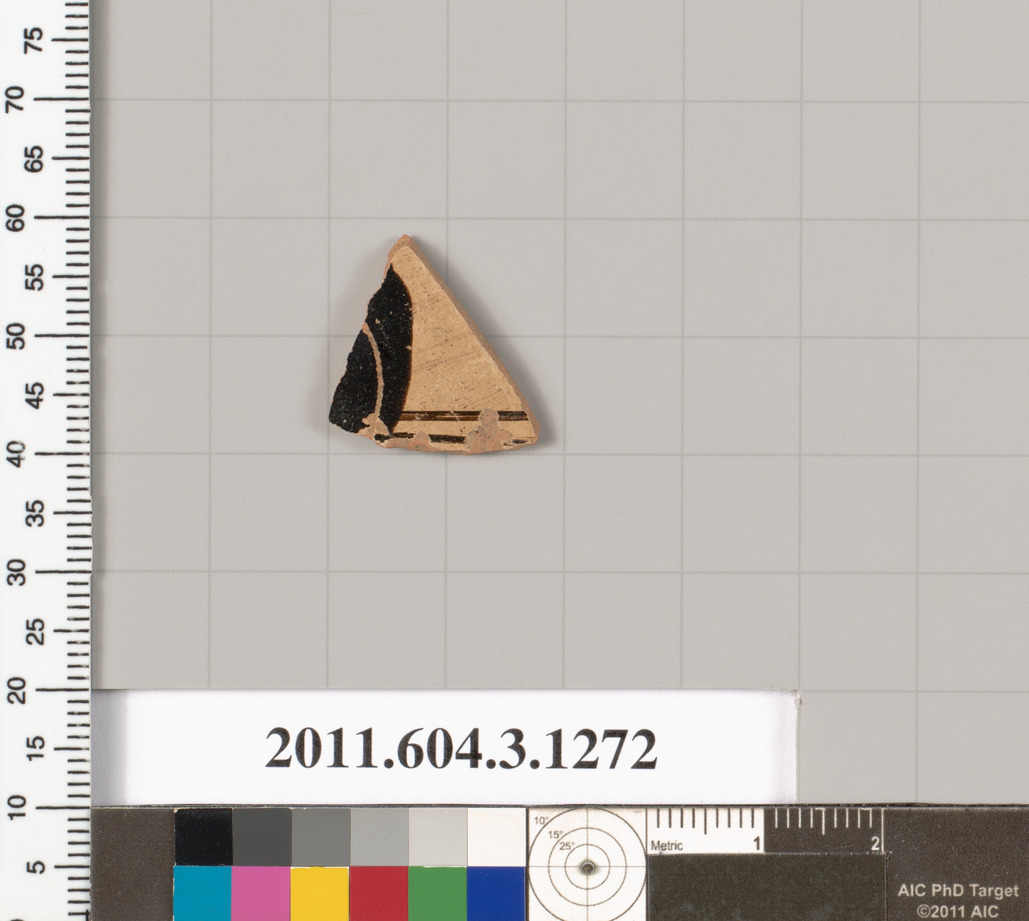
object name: oinochoe fragment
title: Terracotta fragment of an oinochoe (jug)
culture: greek, attic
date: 534-468 BCE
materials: terracotta